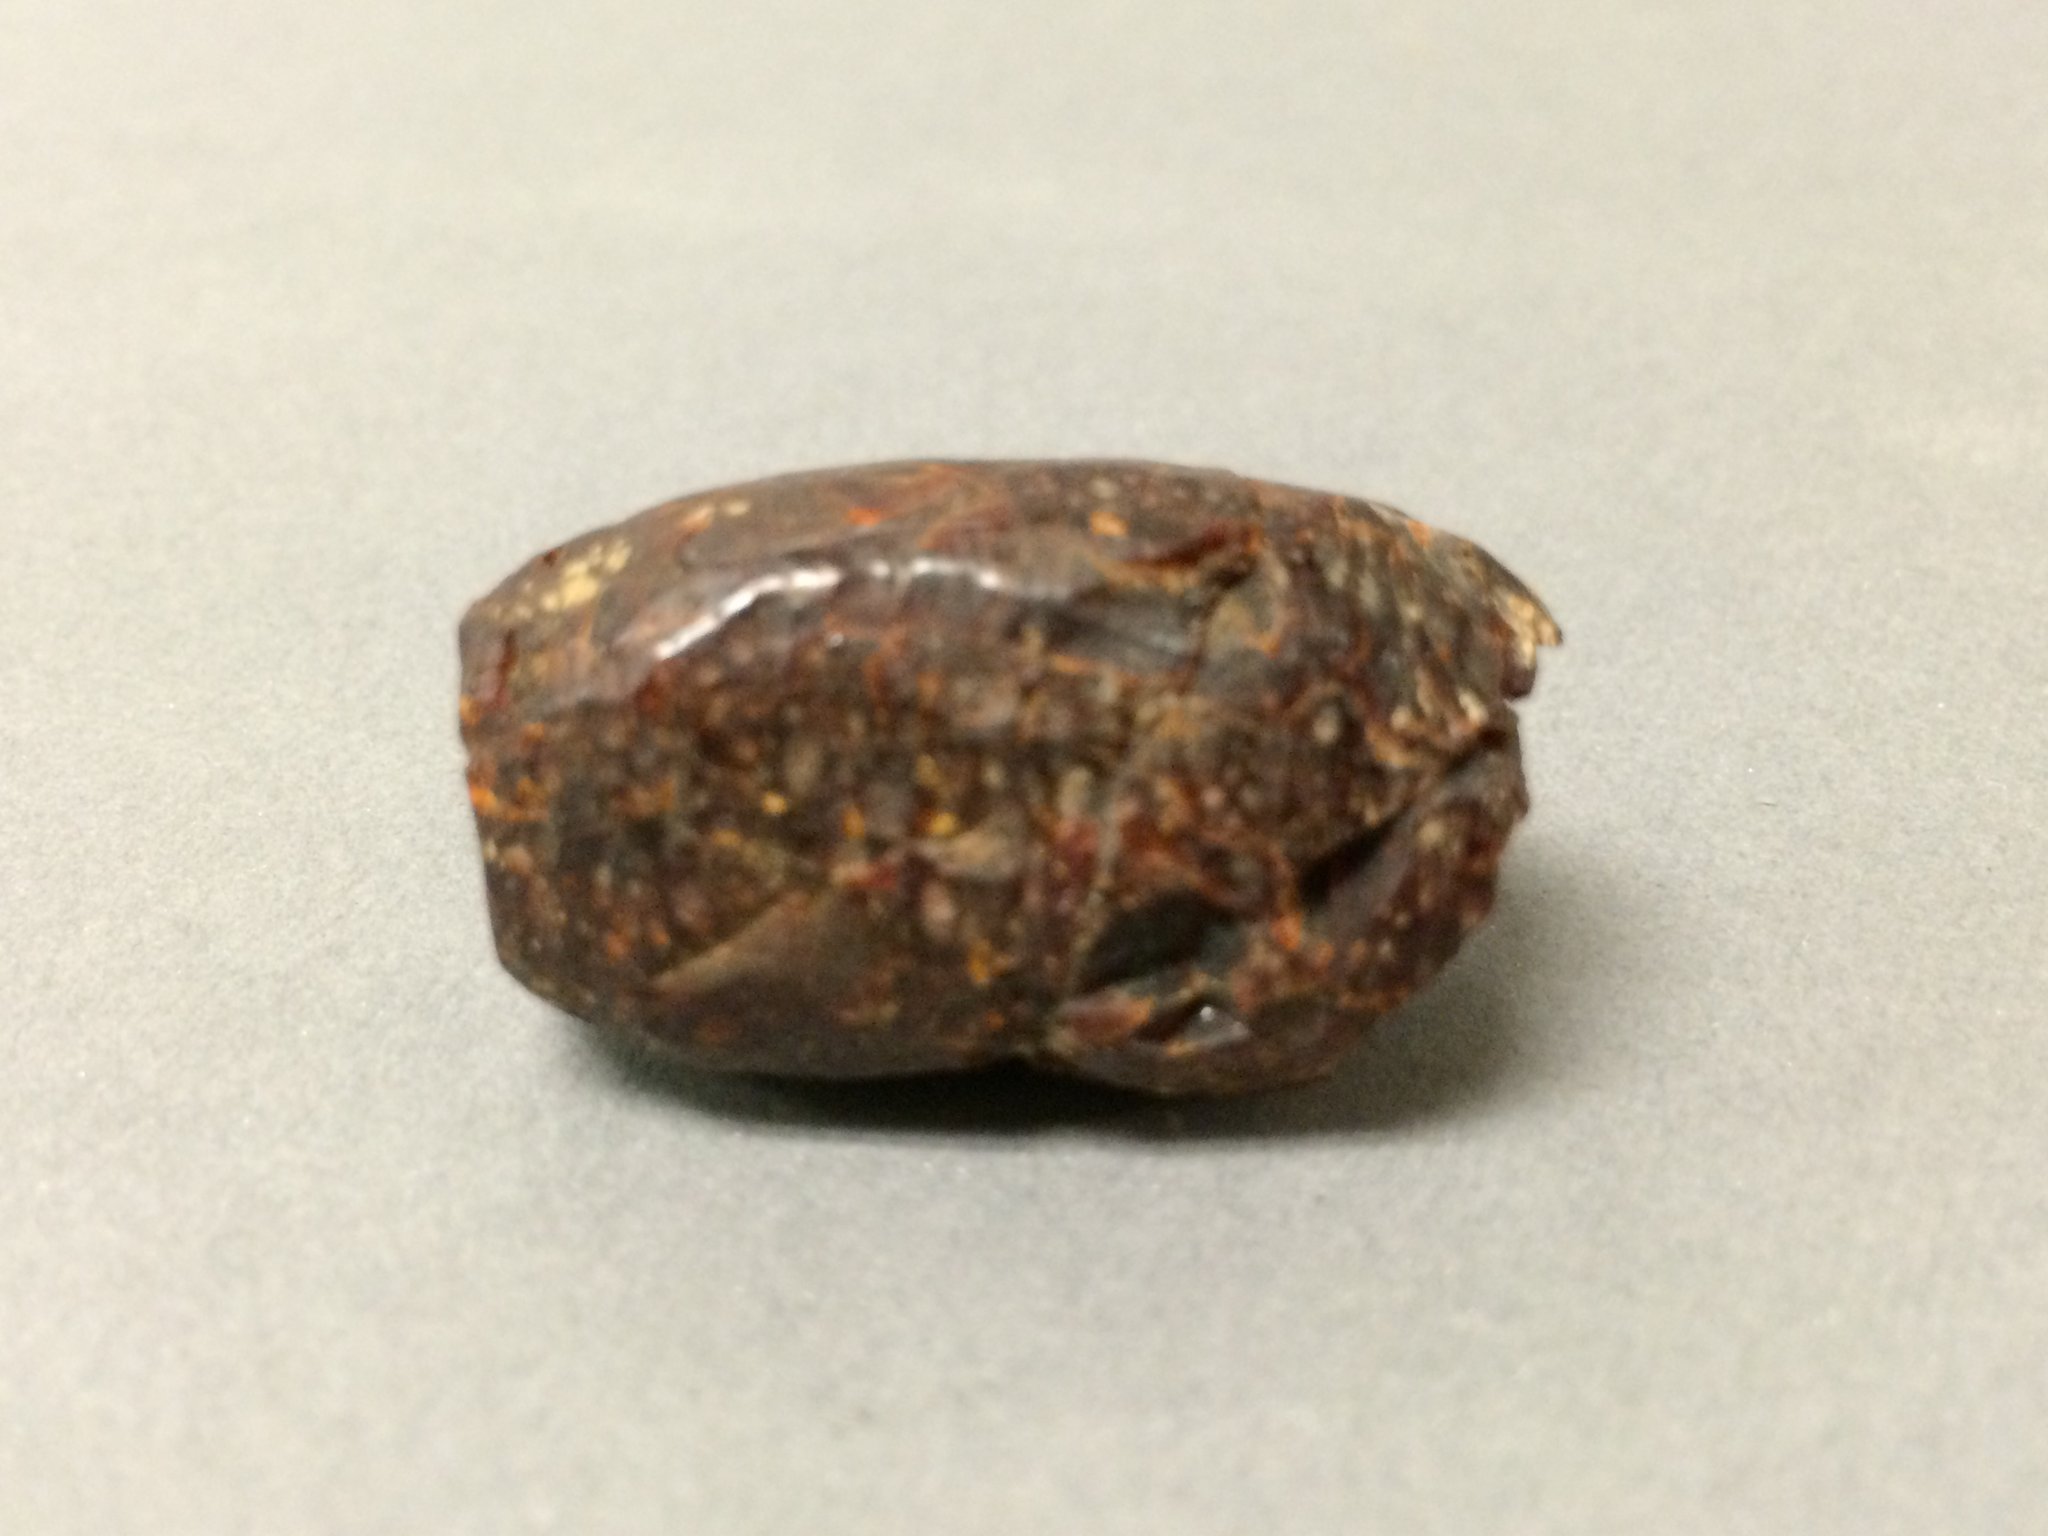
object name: bead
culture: japanese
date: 601-700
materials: stone